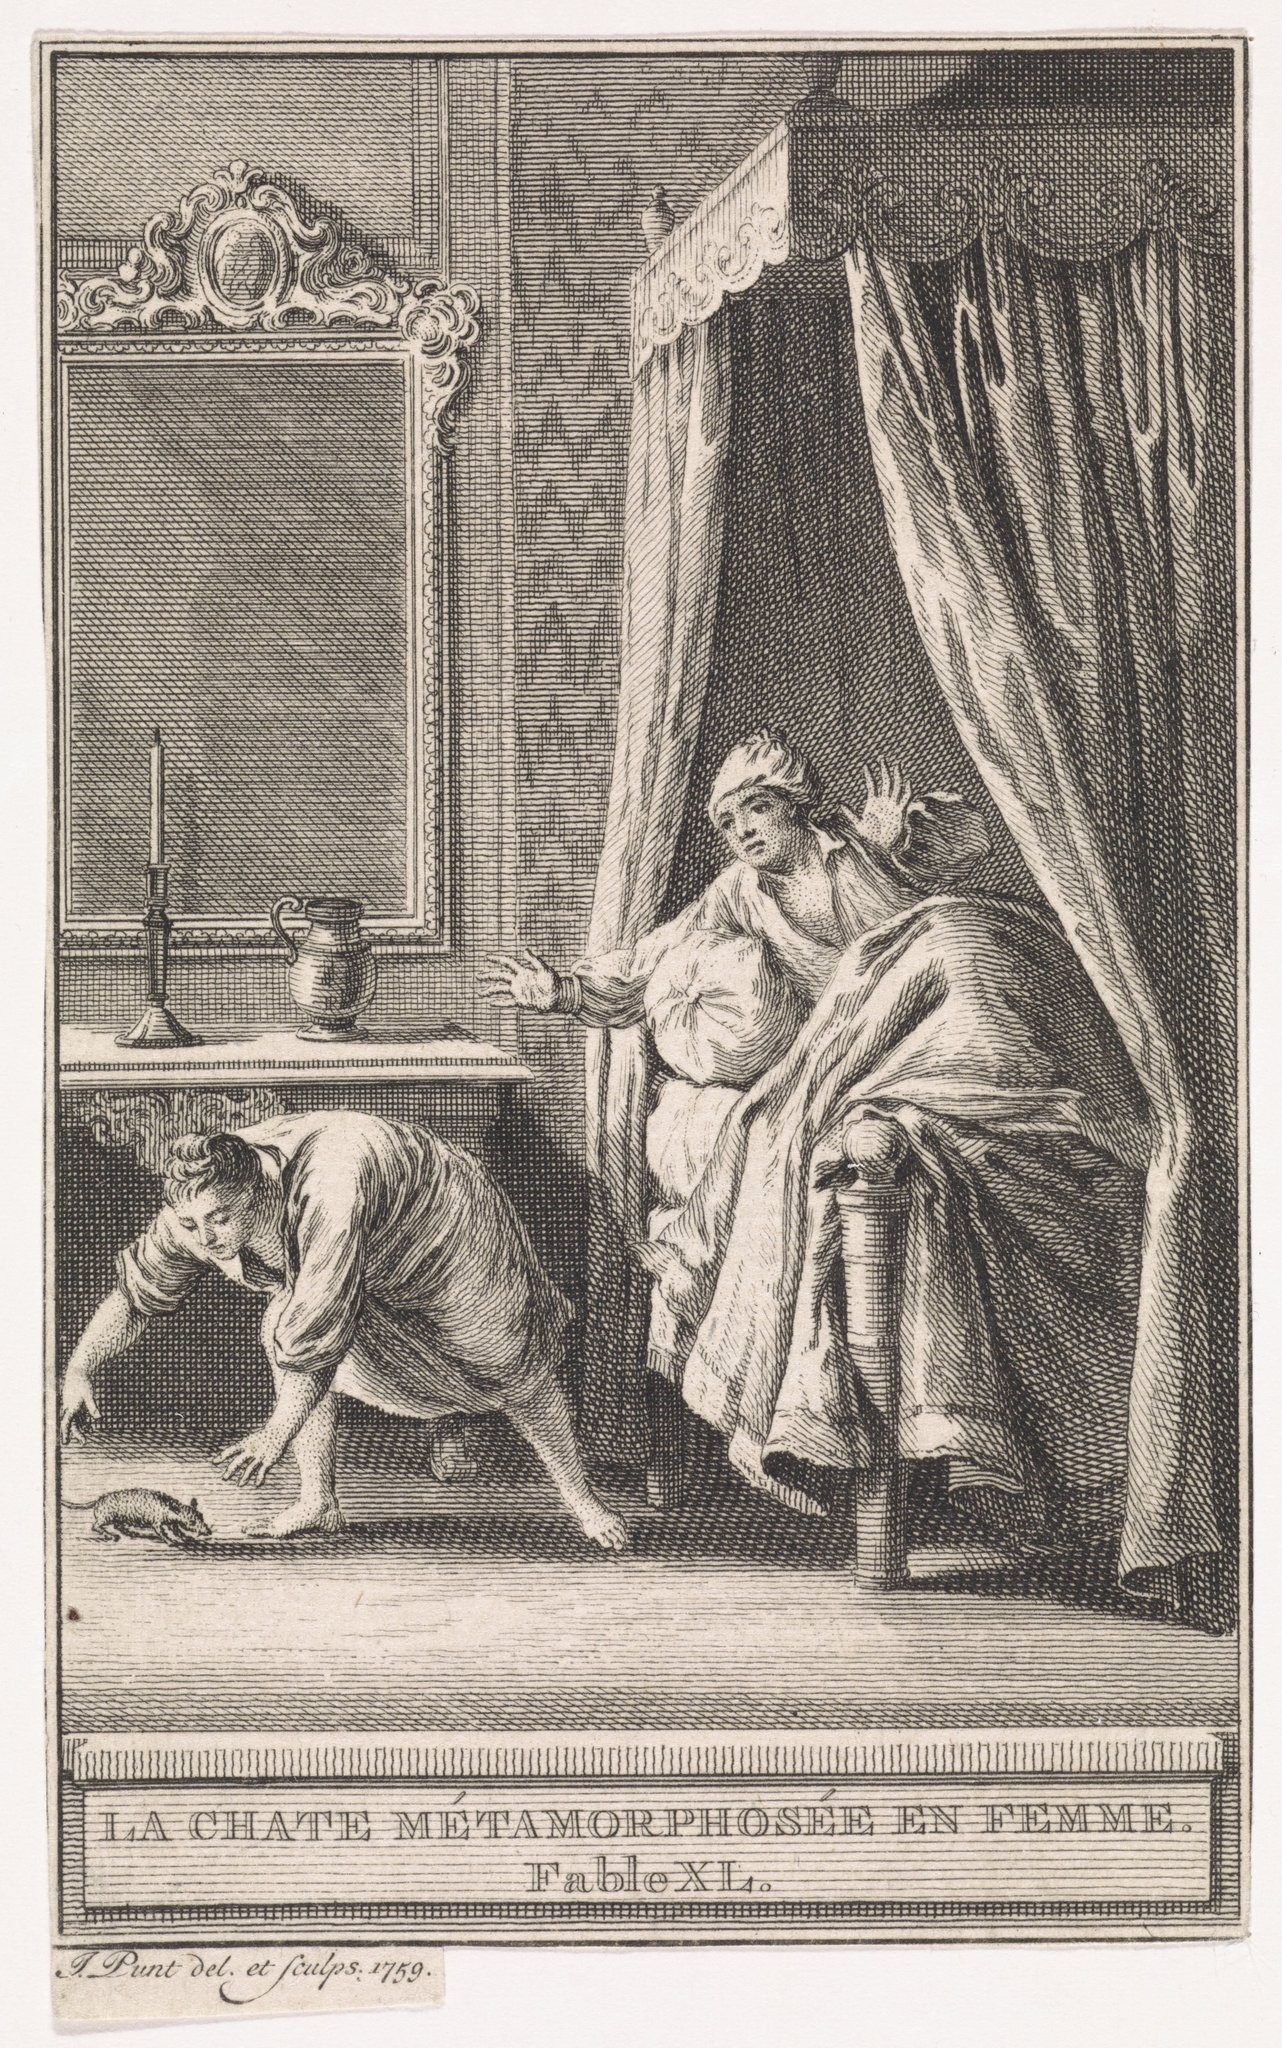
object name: print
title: Vrouw schrikt van muis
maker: jan punt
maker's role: draughtsman, print maker, publisher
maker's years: 1711-1779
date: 1759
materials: paper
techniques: engraving, etching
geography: amsterdam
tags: cat and mouse (+ variant), catching animals, bedroom, specific works of literature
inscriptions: collector's mark: Lugt 2228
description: Prent gebruikt als illustratie in een of meerdere edities van: La Fontaine, Jean de. Fables choisies, deel I, p. 72. Leiden: Elie Luzac, 1764-1786. En in de editie uit Amsterdam: J. van Gulik, 1802.